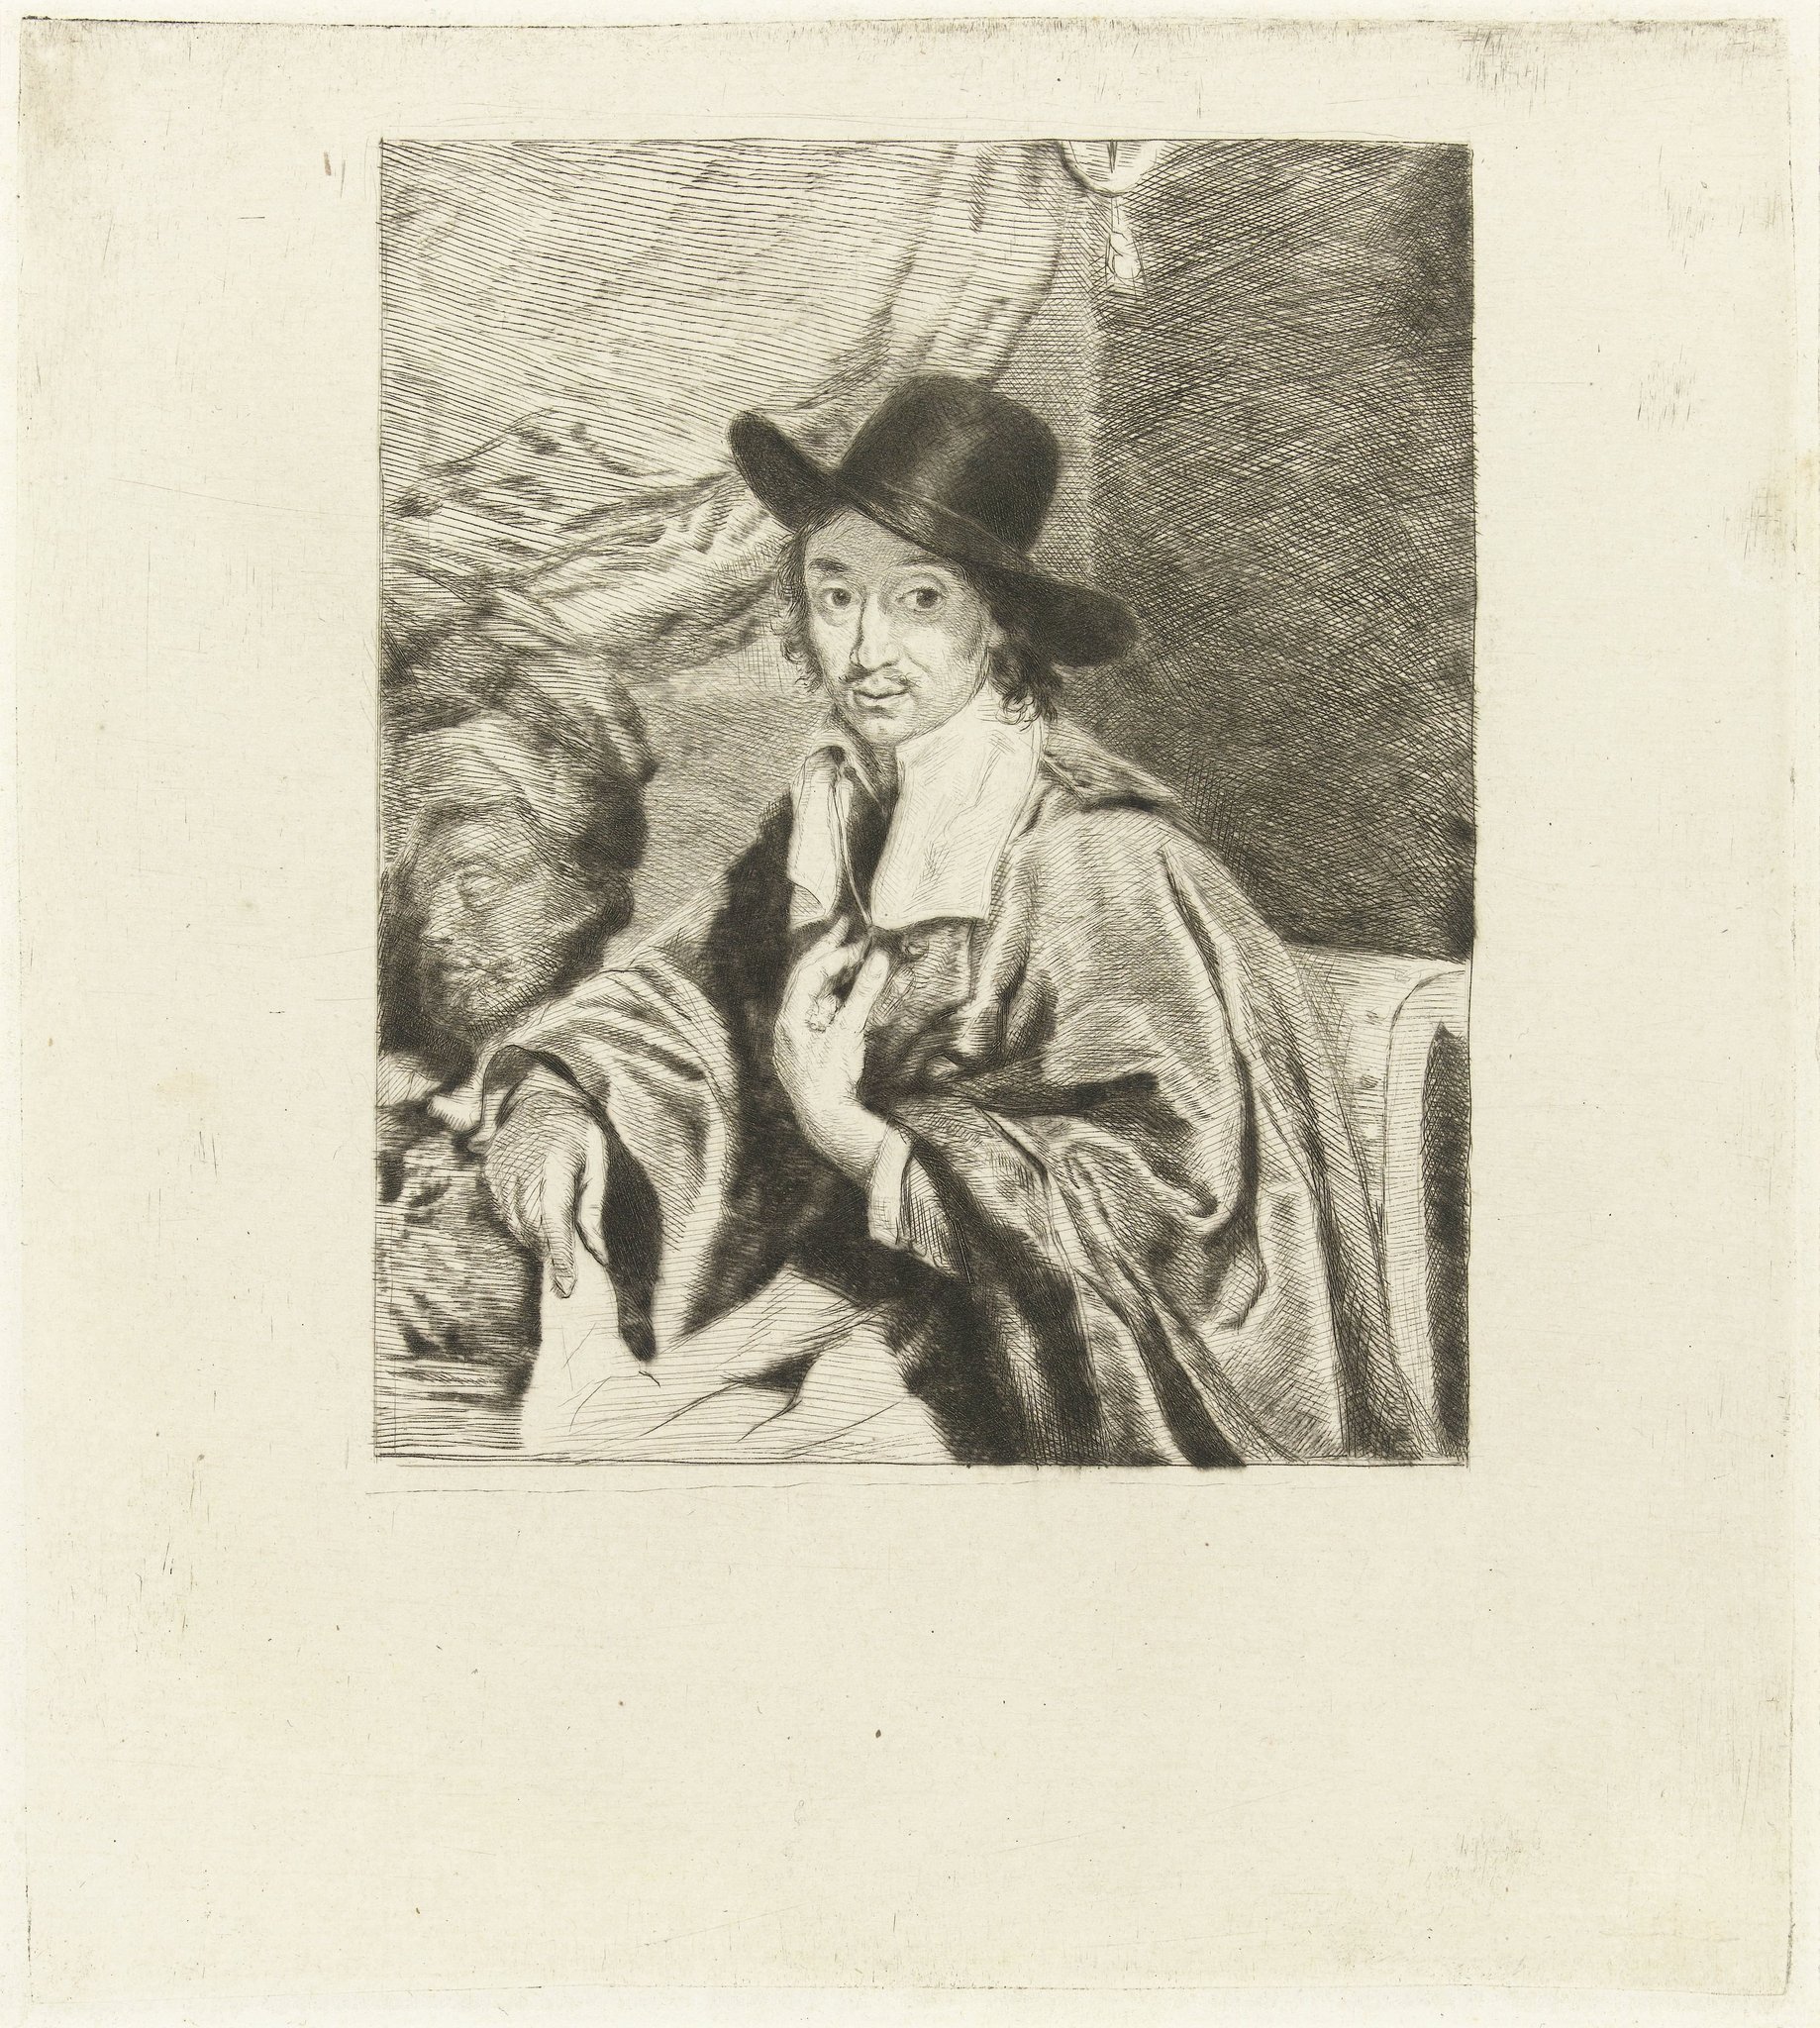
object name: print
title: Portret van de schilder Adriaen van Ostade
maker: louis bernard coclers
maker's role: draughtsman, print maker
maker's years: 1741-1817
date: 1756-1817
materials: paper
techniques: drypoint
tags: haarlem, painter, print maker, draughtsman, adriaen van ostade, portrait, self-portrait of artist (+ artist in non-work situation)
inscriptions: collector's mark: Lugt 2228